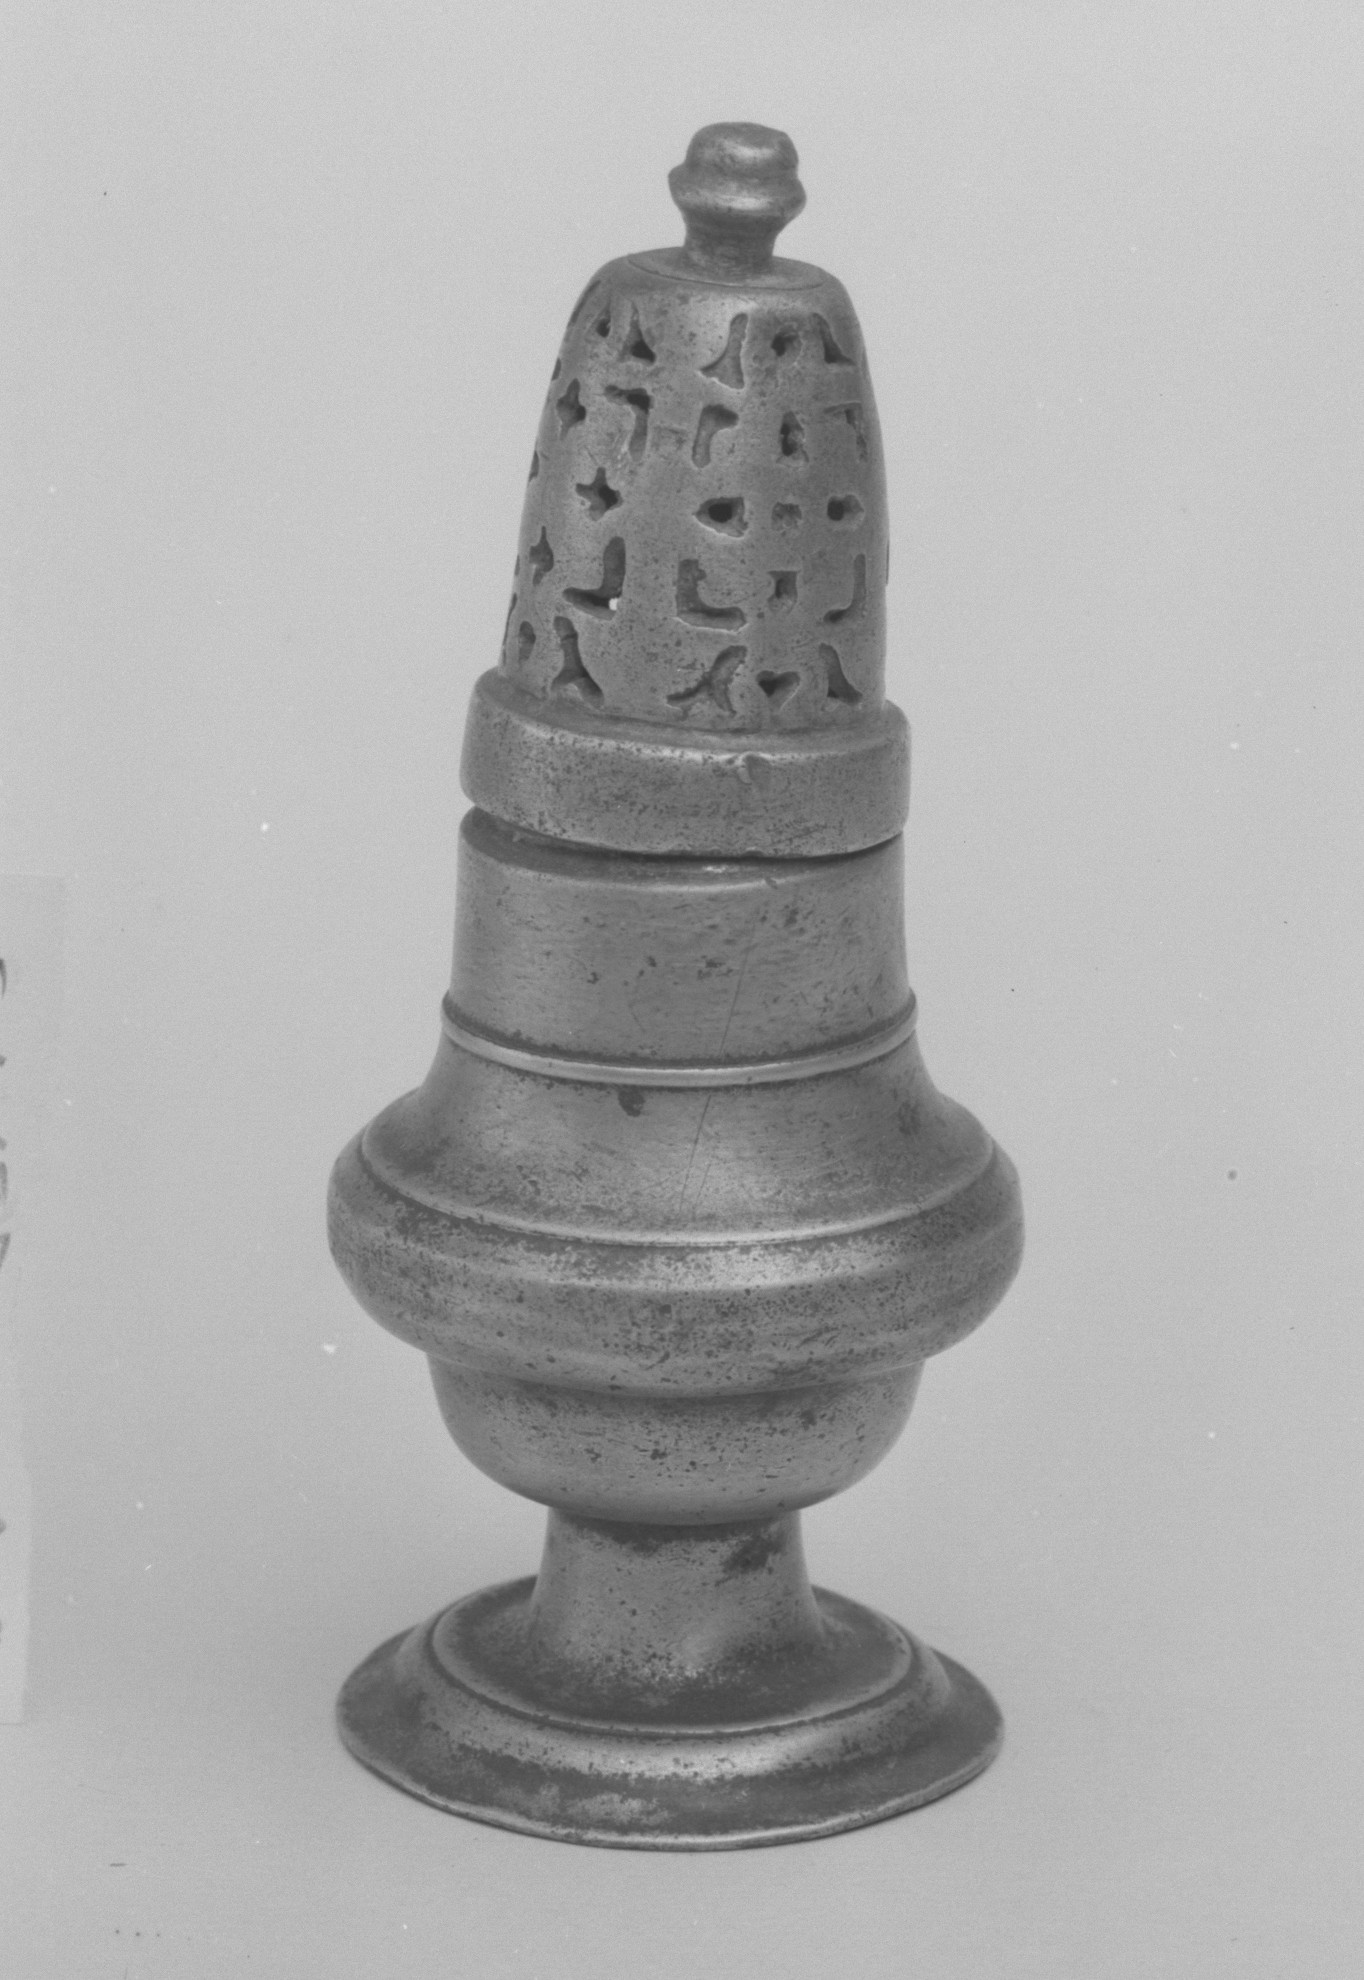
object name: caster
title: Pair of casters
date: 1701-1800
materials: pewter